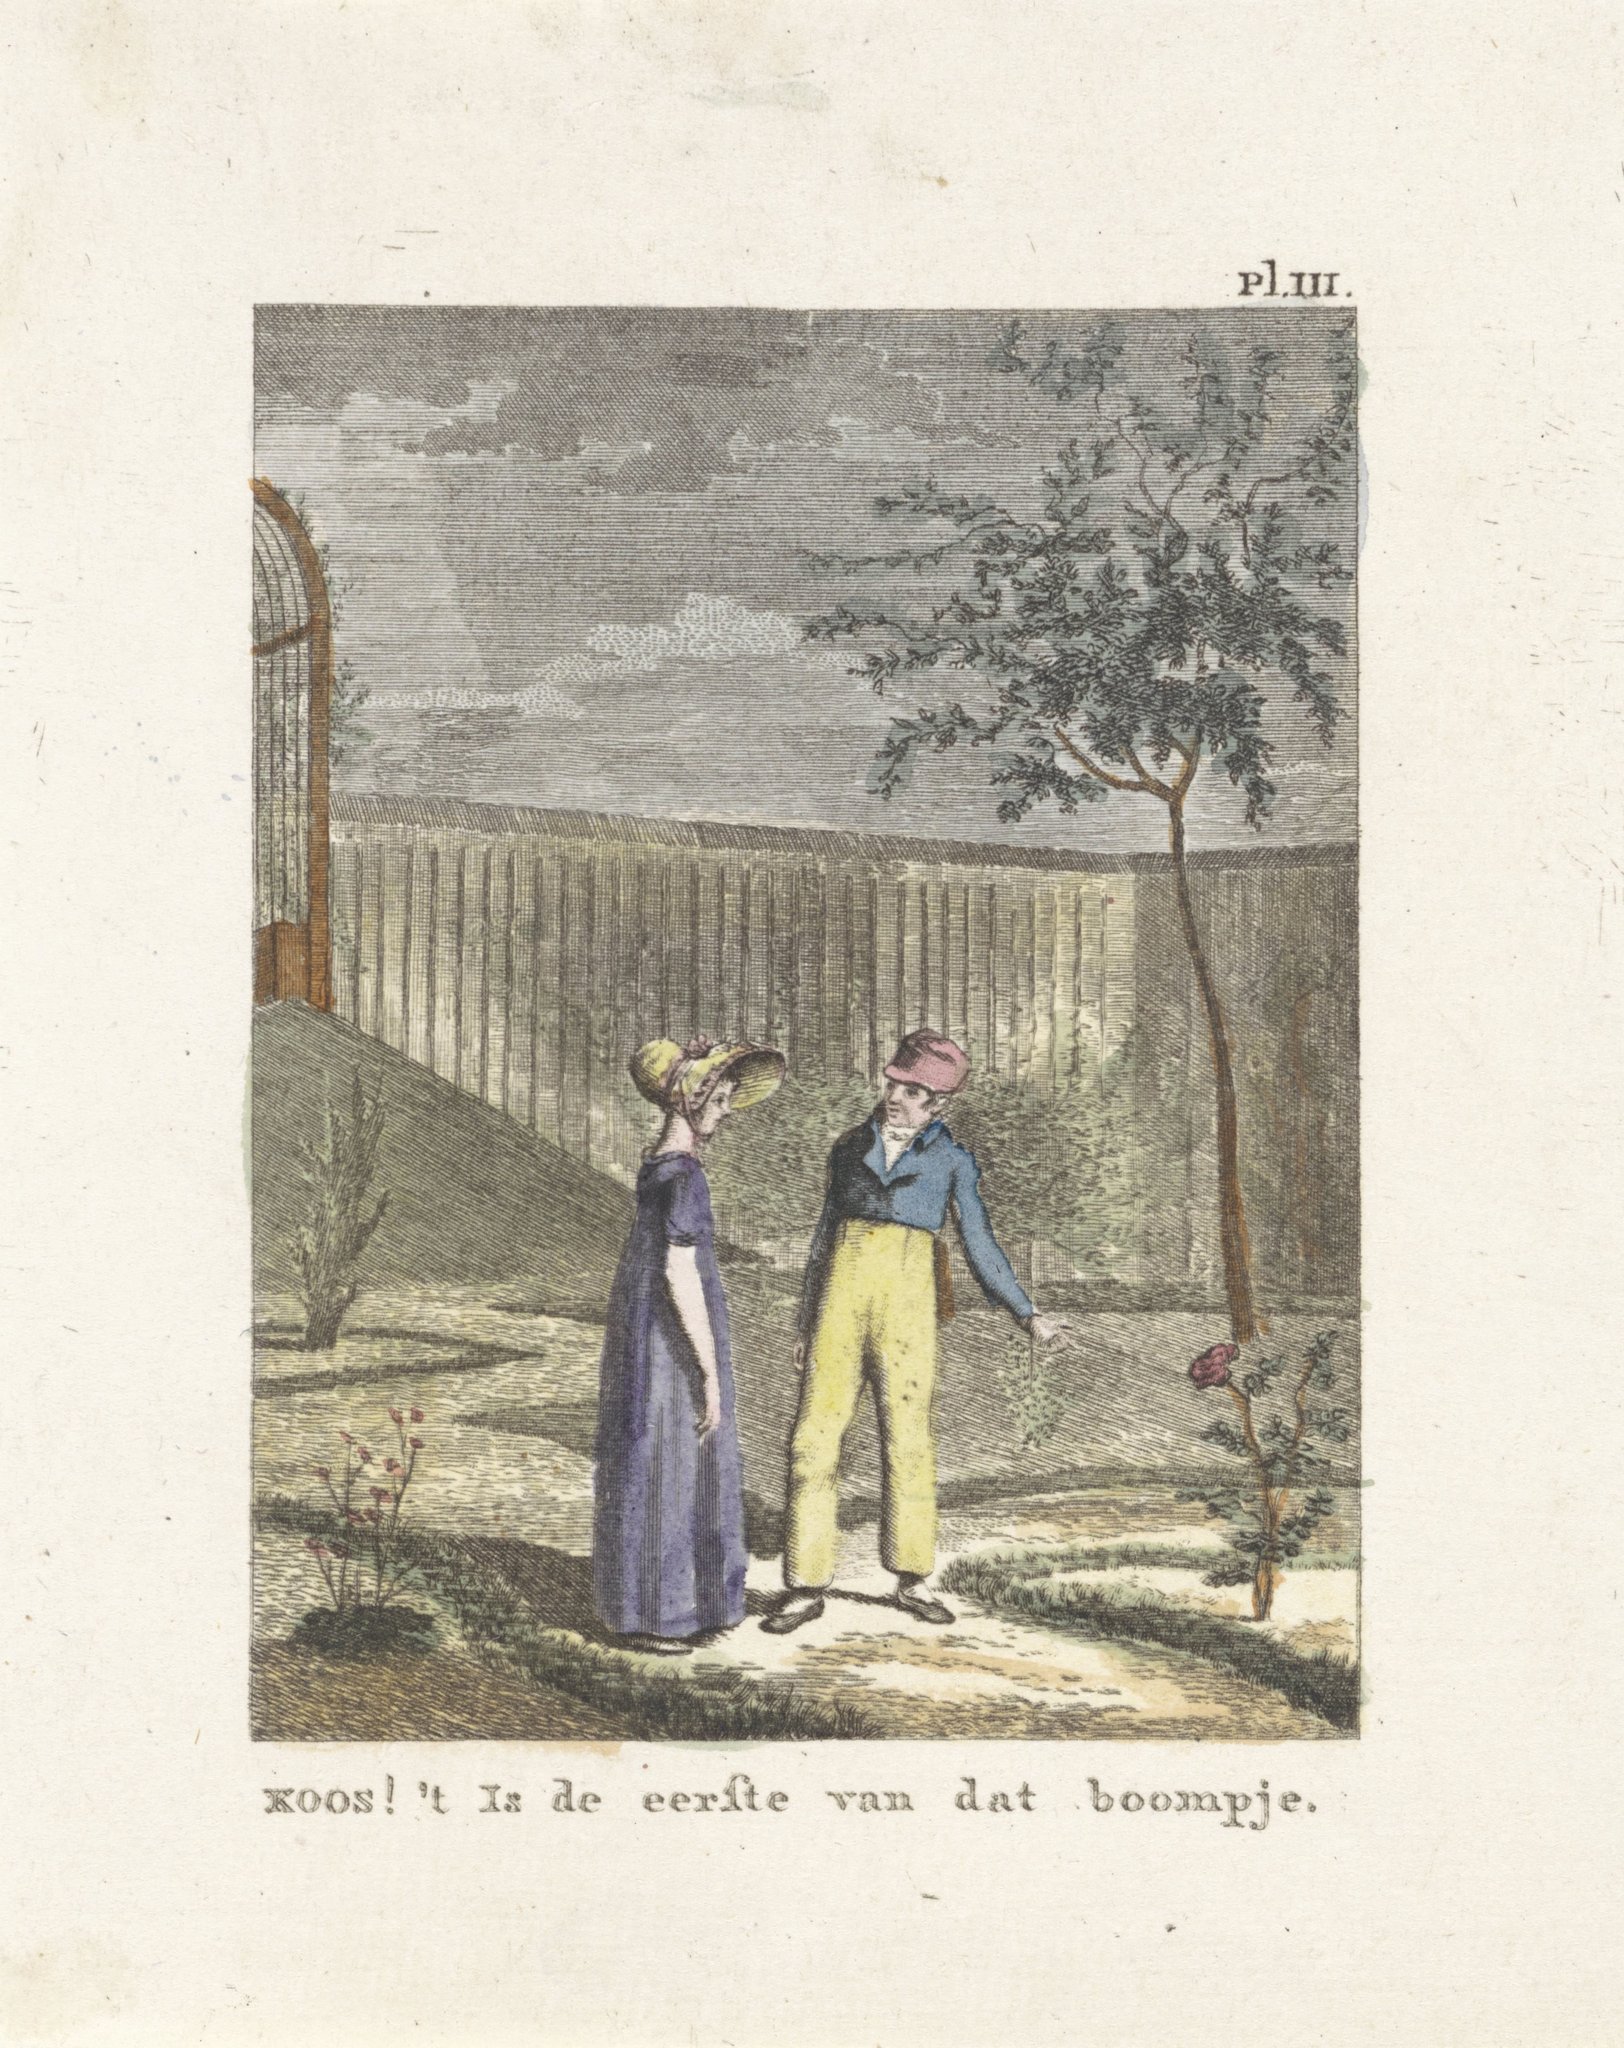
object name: print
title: Koos! 't Is de eerste van dat boompje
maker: izaak jansz. de wit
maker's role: draughtsman, print maker, publisher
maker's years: 1744-1809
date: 1806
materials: paper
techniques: etching, hand coloring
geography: haarlem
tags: garden, fence, wall, paling, flowers: rose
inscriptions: collector's mark: Lugt 2228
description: Prent gebruikt in: Moens, Petronella. Letter-kransje voor lieve en brave kinderen. Haarlem: Adriaan Pietrsz. Loosjes, 1806.